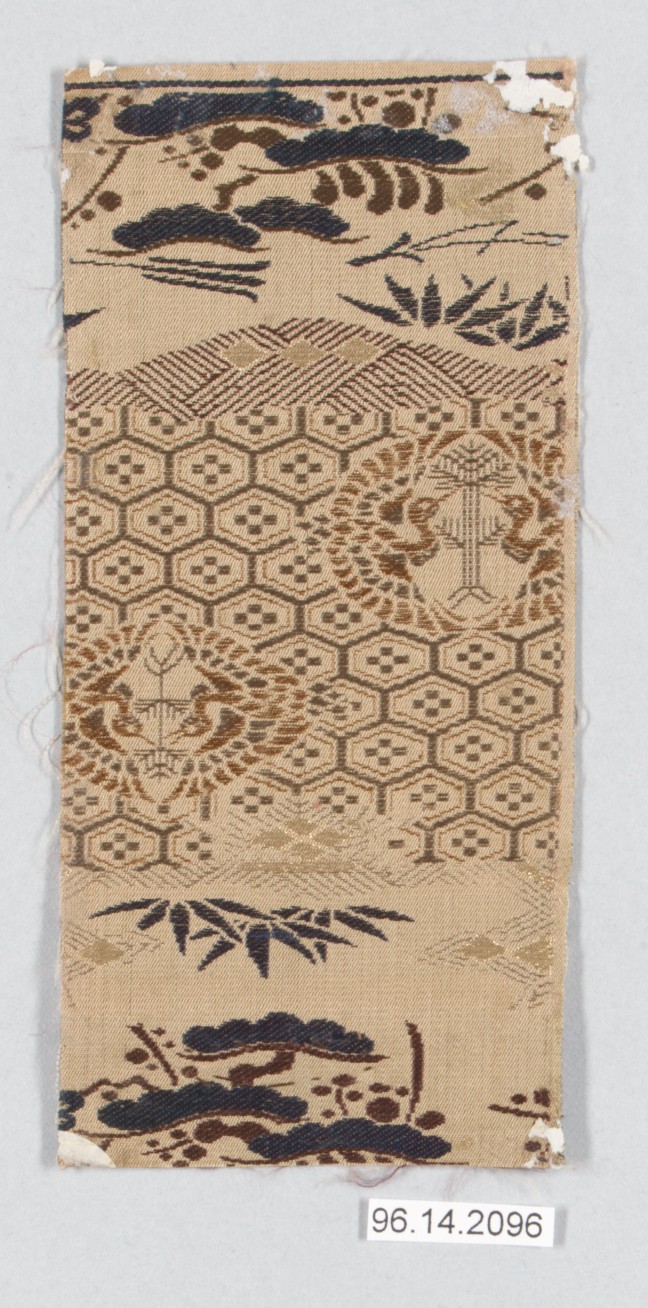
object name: piece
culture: japanese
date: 1701-1900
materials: silk